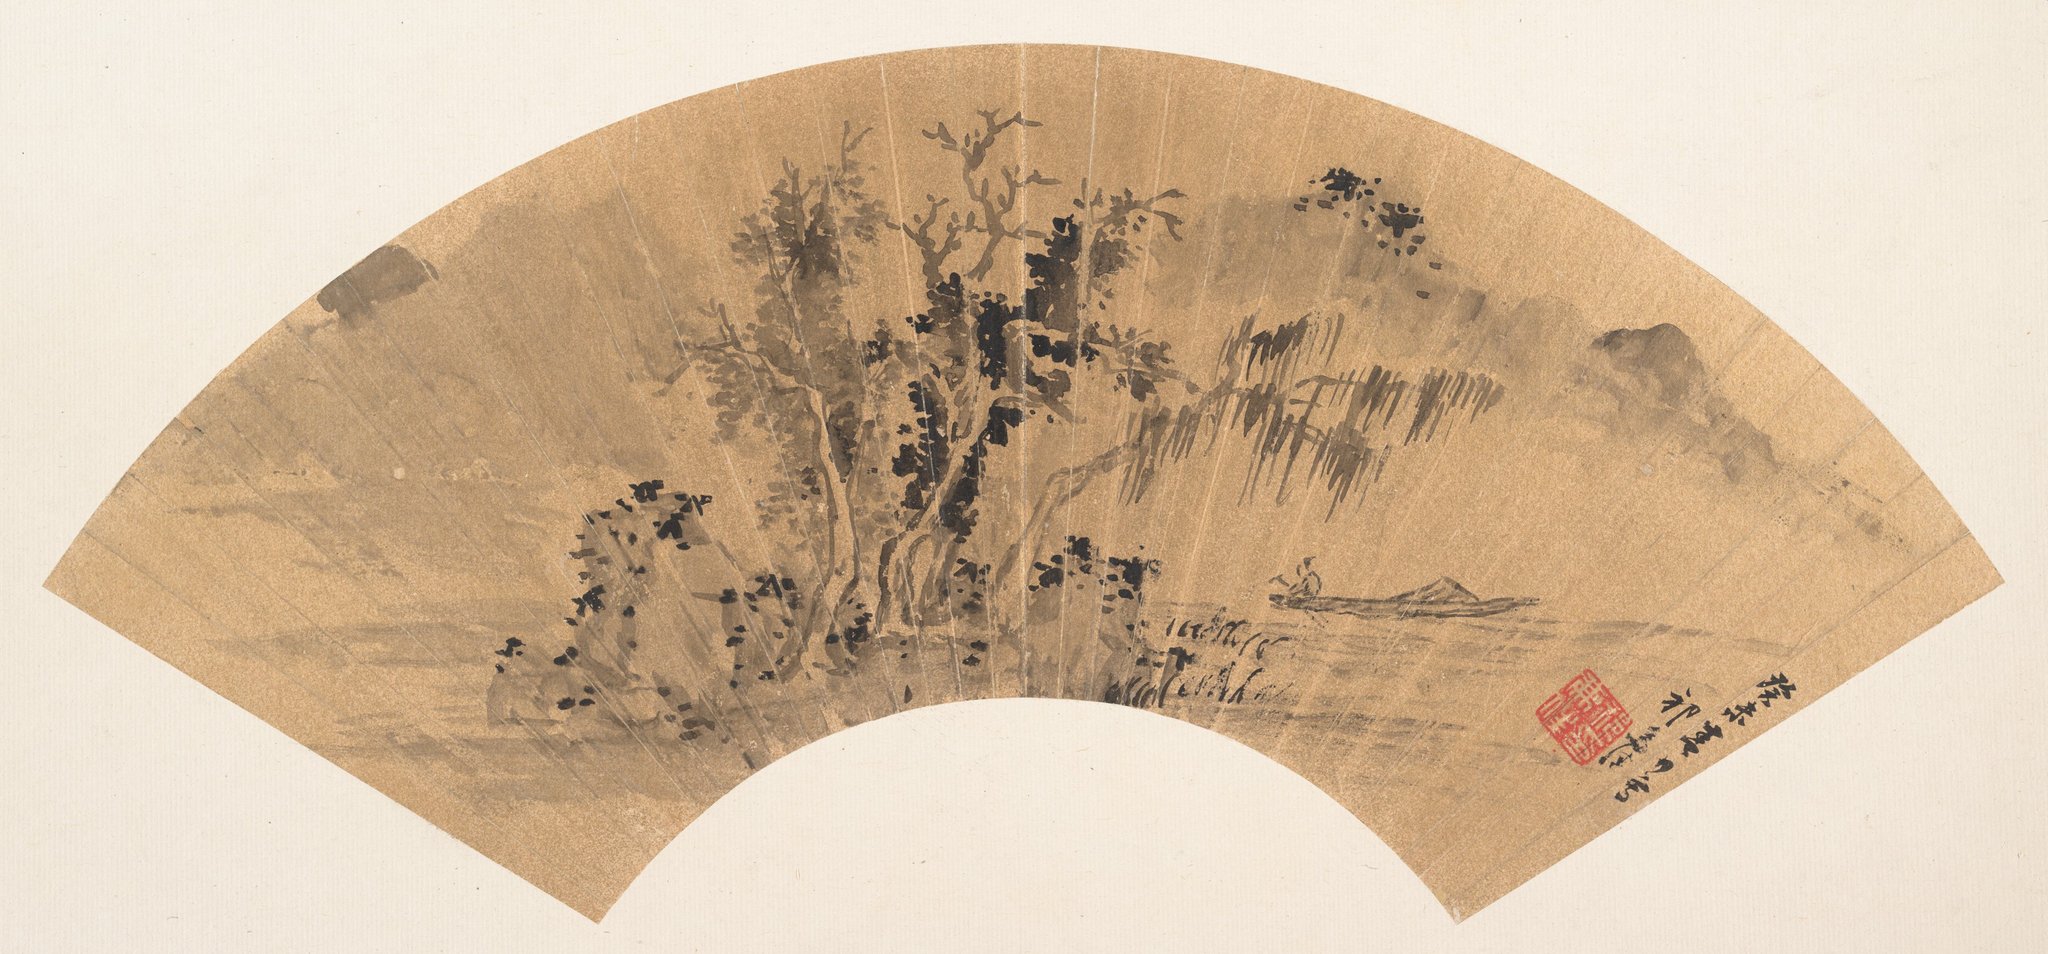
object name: folding fan mounted a an album leaf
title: Landscape with fisherman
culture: chinese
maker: qi zhijia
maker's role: artist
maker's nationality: chinese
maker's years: 1627-1682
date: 1643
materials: ink, paper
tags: landscapes